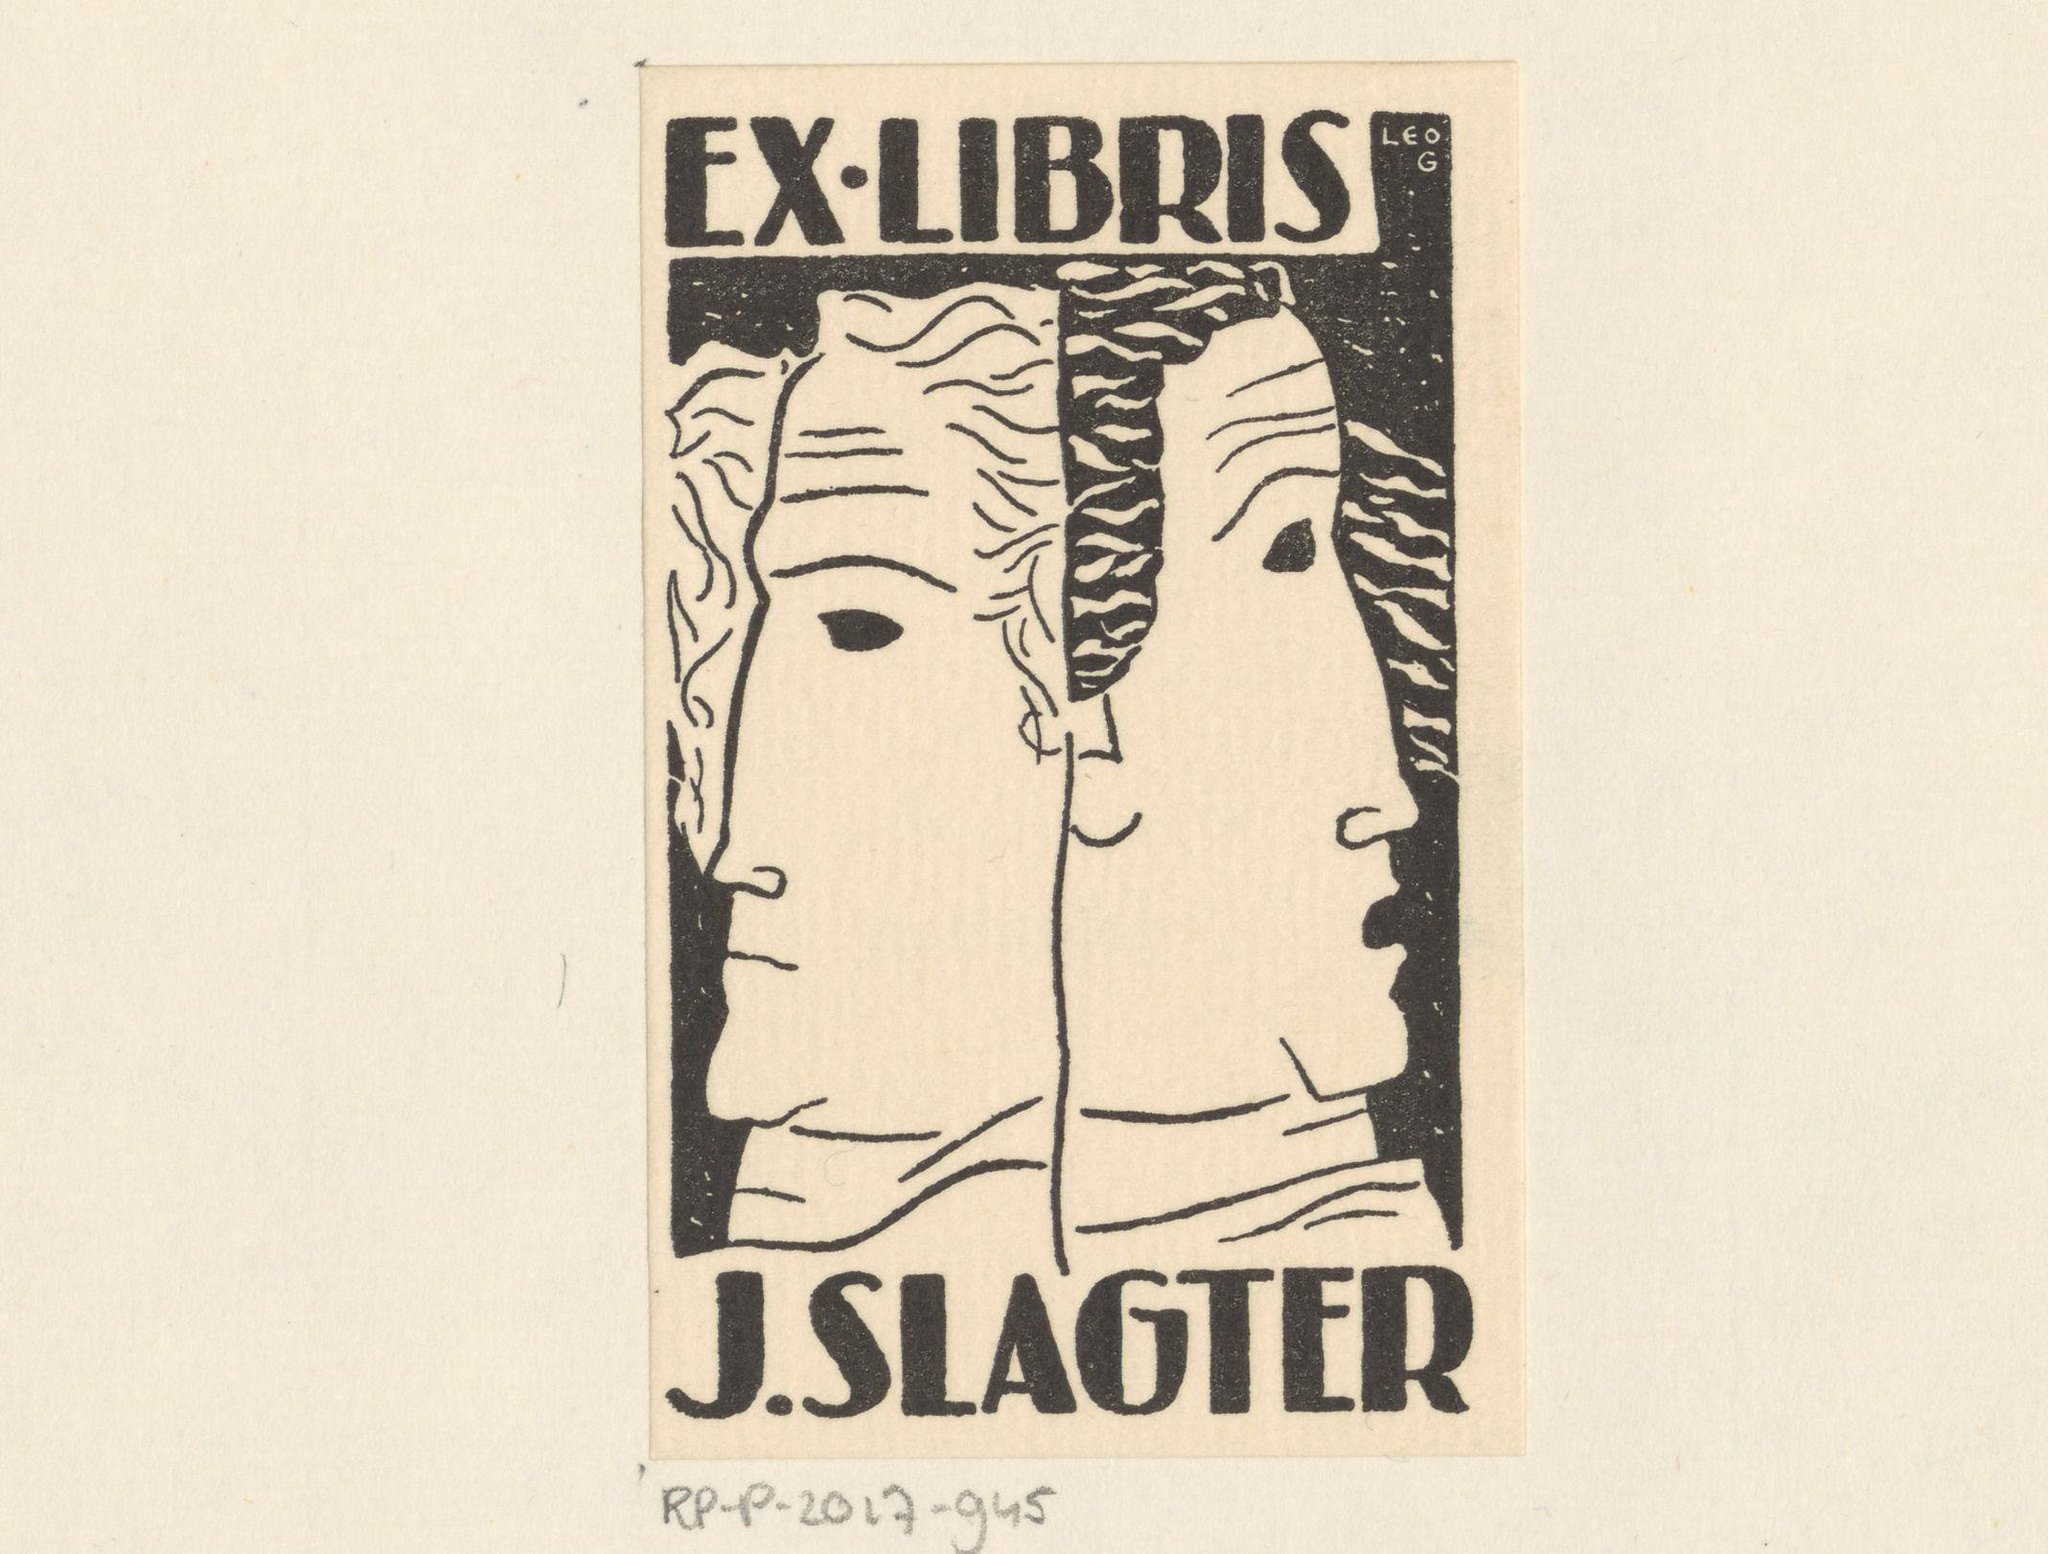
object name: bookplate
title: Ex libris van J. Slagter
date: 1933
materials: paper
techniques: printing block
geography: netherlands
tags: adult man, head turned sideways